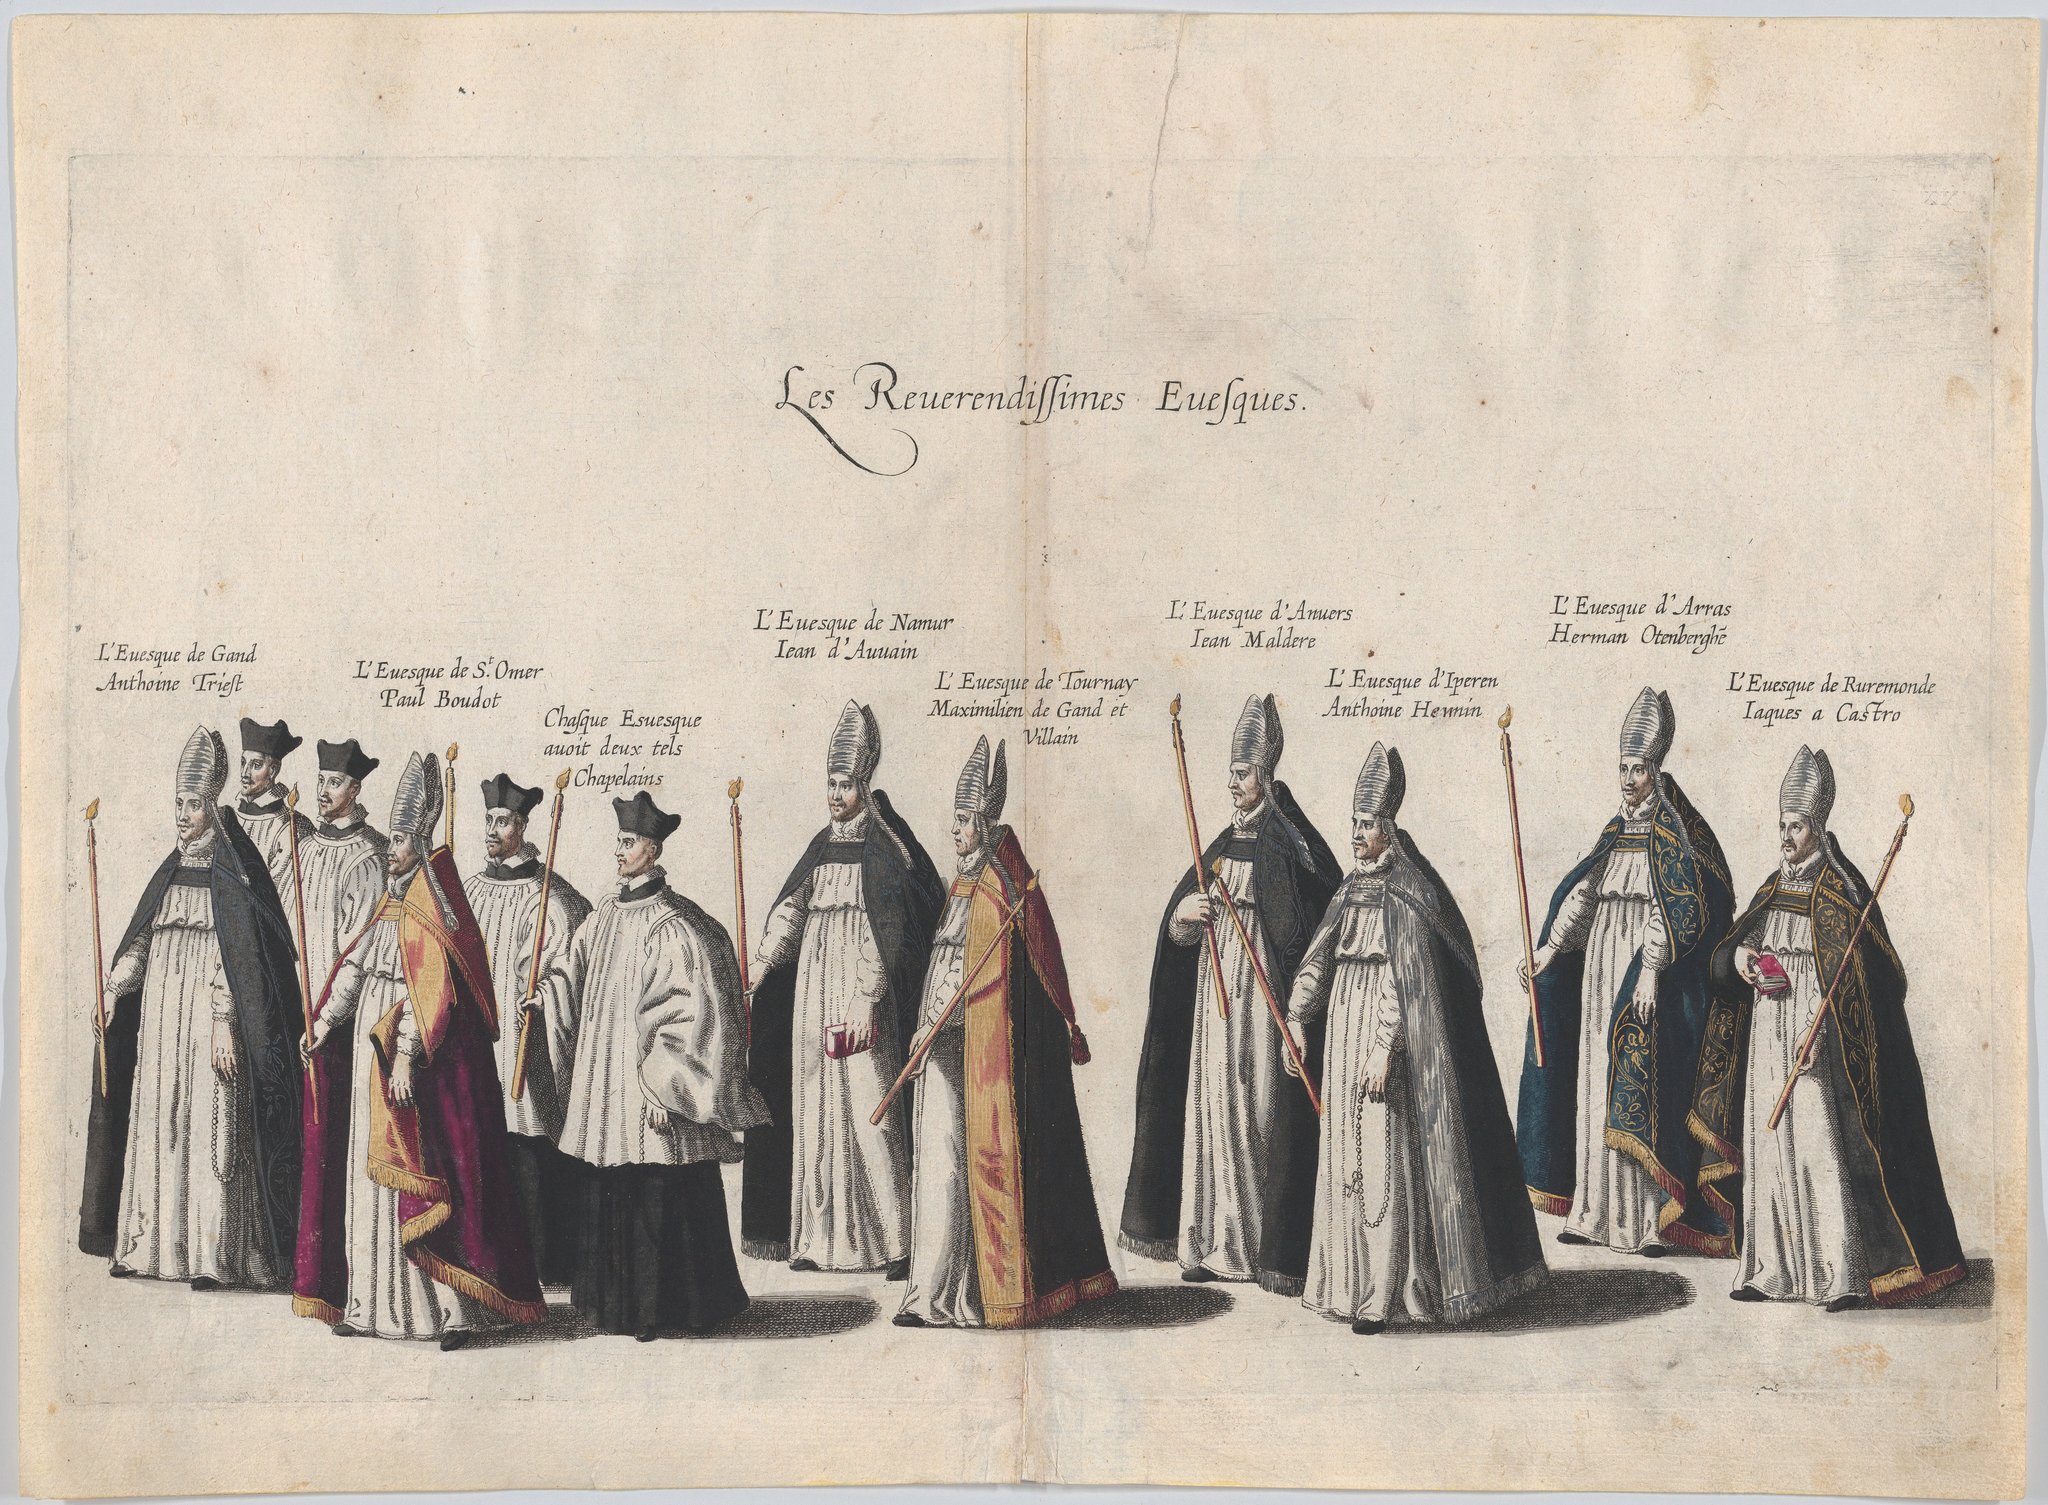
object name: print, fete, ornament architecture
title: Plate 12: Members of the clergy marching in the funeral procession of Archduke Albert of Austria; from 'Pompa Funebris ... Alberti Pii'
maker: cornelis galle (i)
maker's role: artist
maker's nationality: netherlandish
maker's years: 1576-1650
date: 1623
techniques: etching, hand coloring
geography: brussels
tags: men,funerals